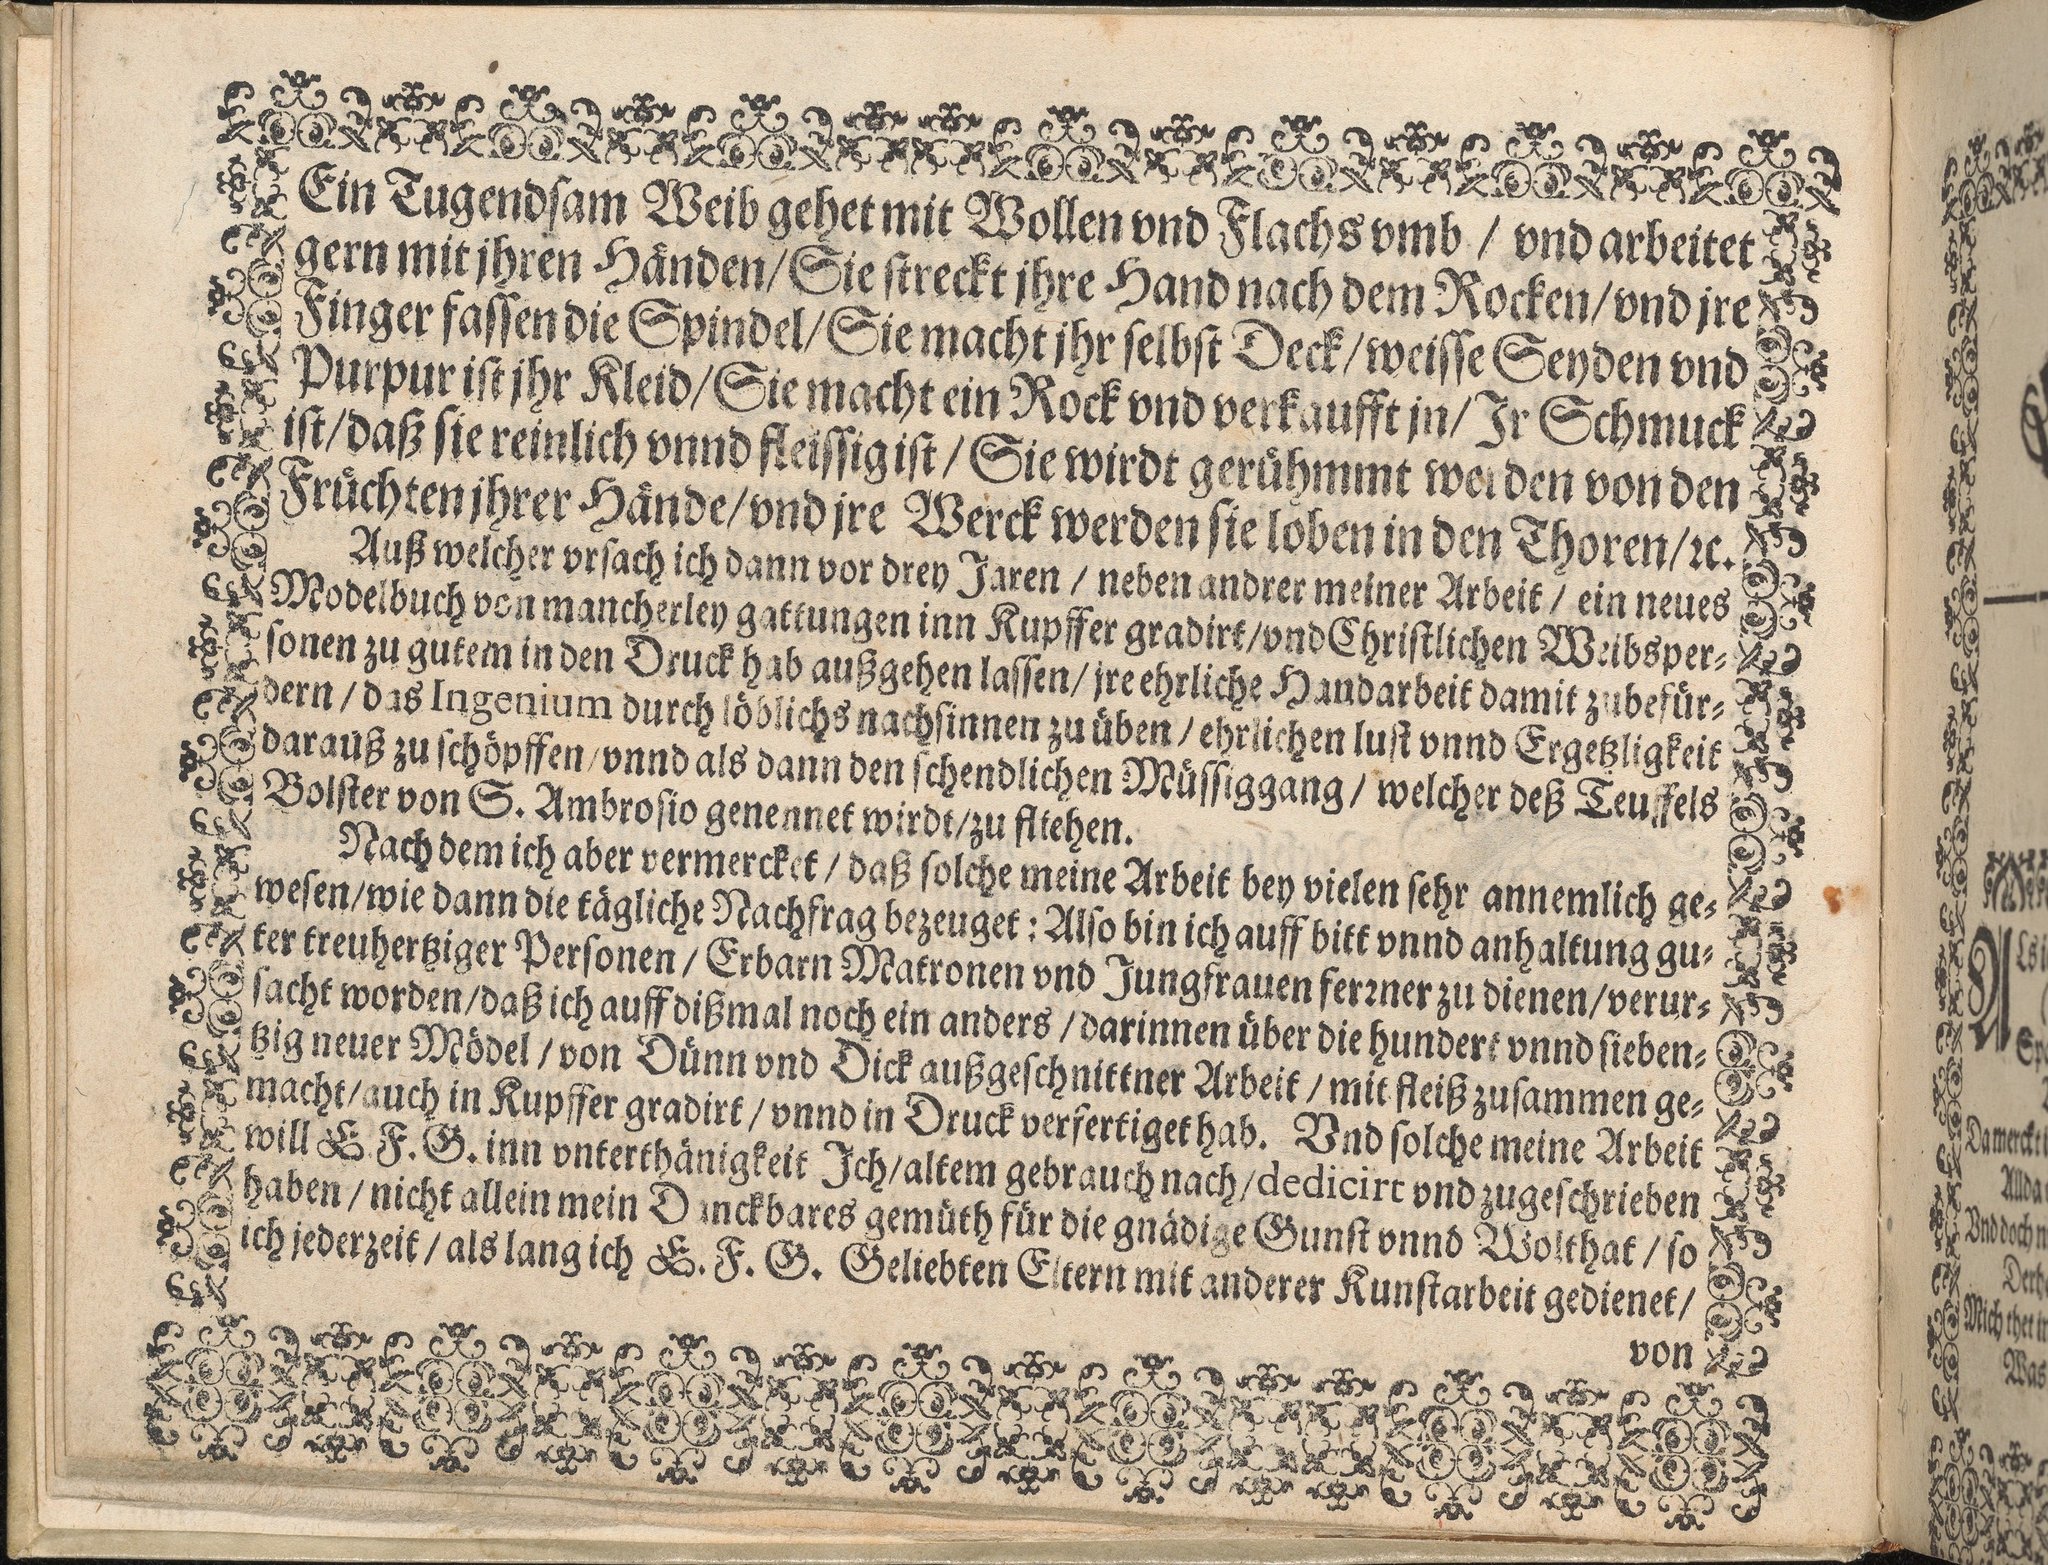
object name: book print ornament architecture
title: Newes Modelbuch in Kupffer (Page, 3v)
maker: johann sibmacher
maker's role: artist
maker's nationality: german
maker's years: 1590-1611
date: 1604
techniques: woodcut